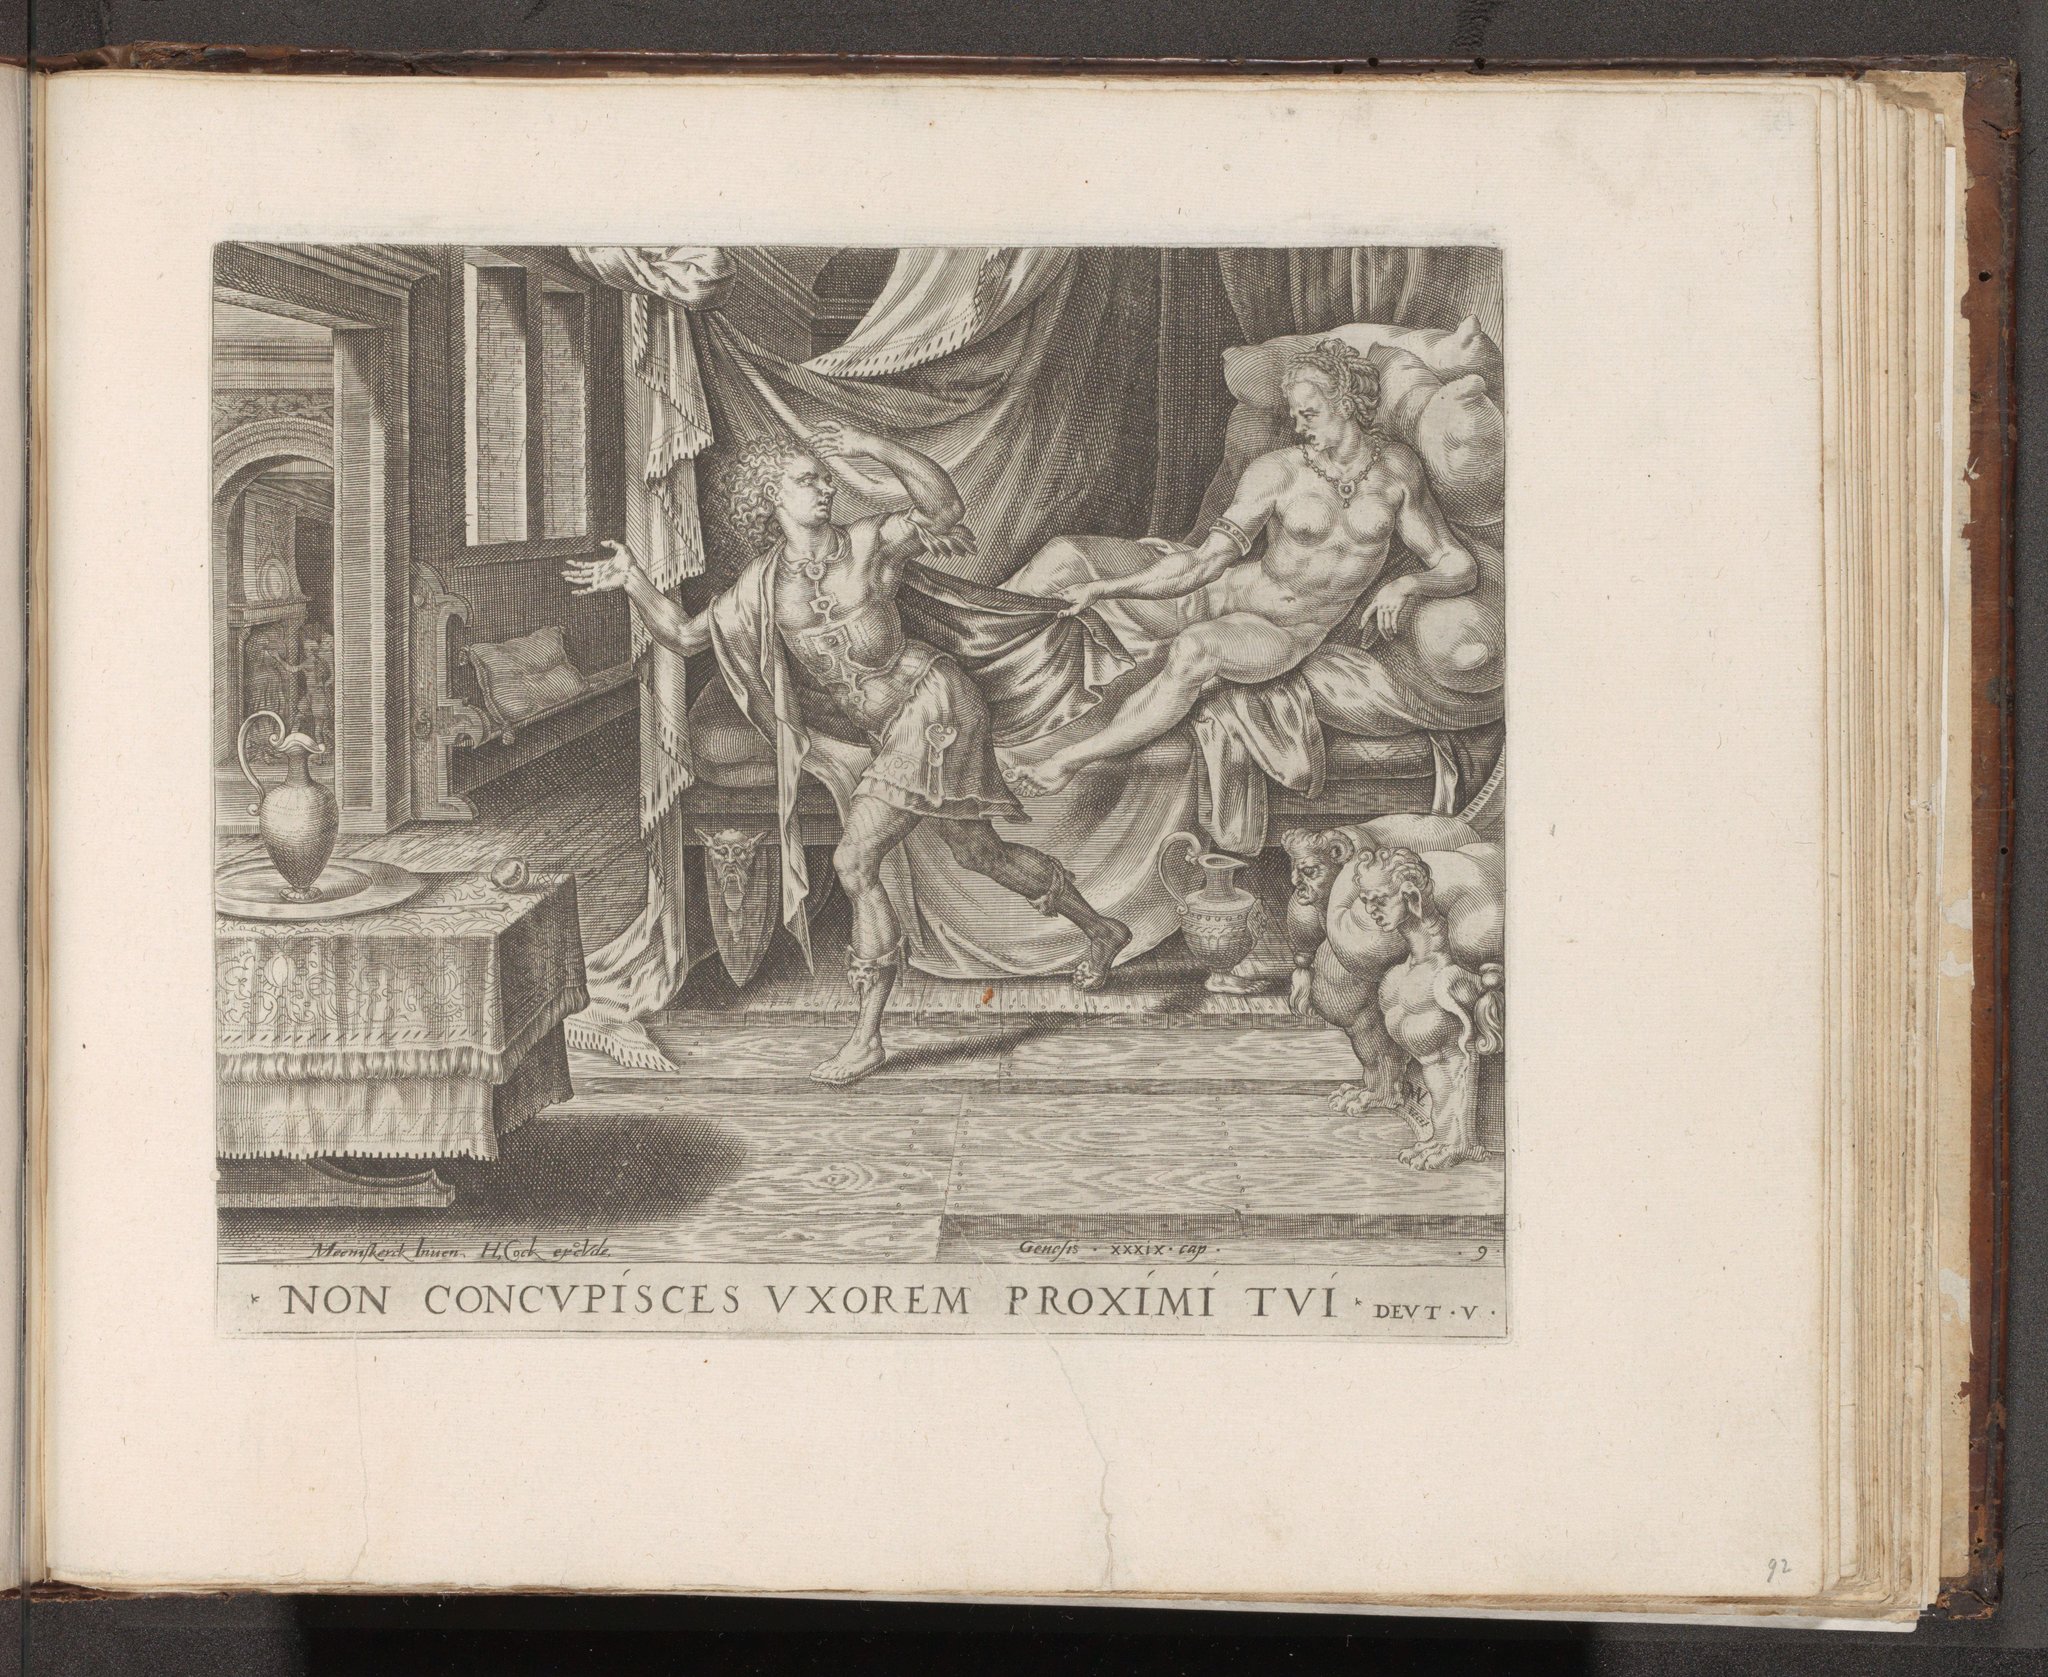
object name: print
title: Jozef en de vrouw van Potifar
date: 1564-1568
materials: paper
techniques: engraving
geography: amsterdam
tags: potiphar's wife catches joseph by his robe, usually while lying in bed; joseph escapes leaving his cloak behind in her hands (possibly with a naked child lying in a crib), 'you shall not covet' ~ separate representation of the tenth of the ten commandments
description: Jozef vlucht voor de vrouw van Potifar, die naakt op haar bed ligt. Zij grijpt zijn kleed vast. Prent maakt deel uit van een serie over de tien geboden en geeft een illustratie van het negende gebod weer: Gij zult niet begeren de vrouw van uw naaste. Onderaan in de marge een verwijzing naar de Bijbeltekst in het Latijn. Prent maakt deel uit van een album.